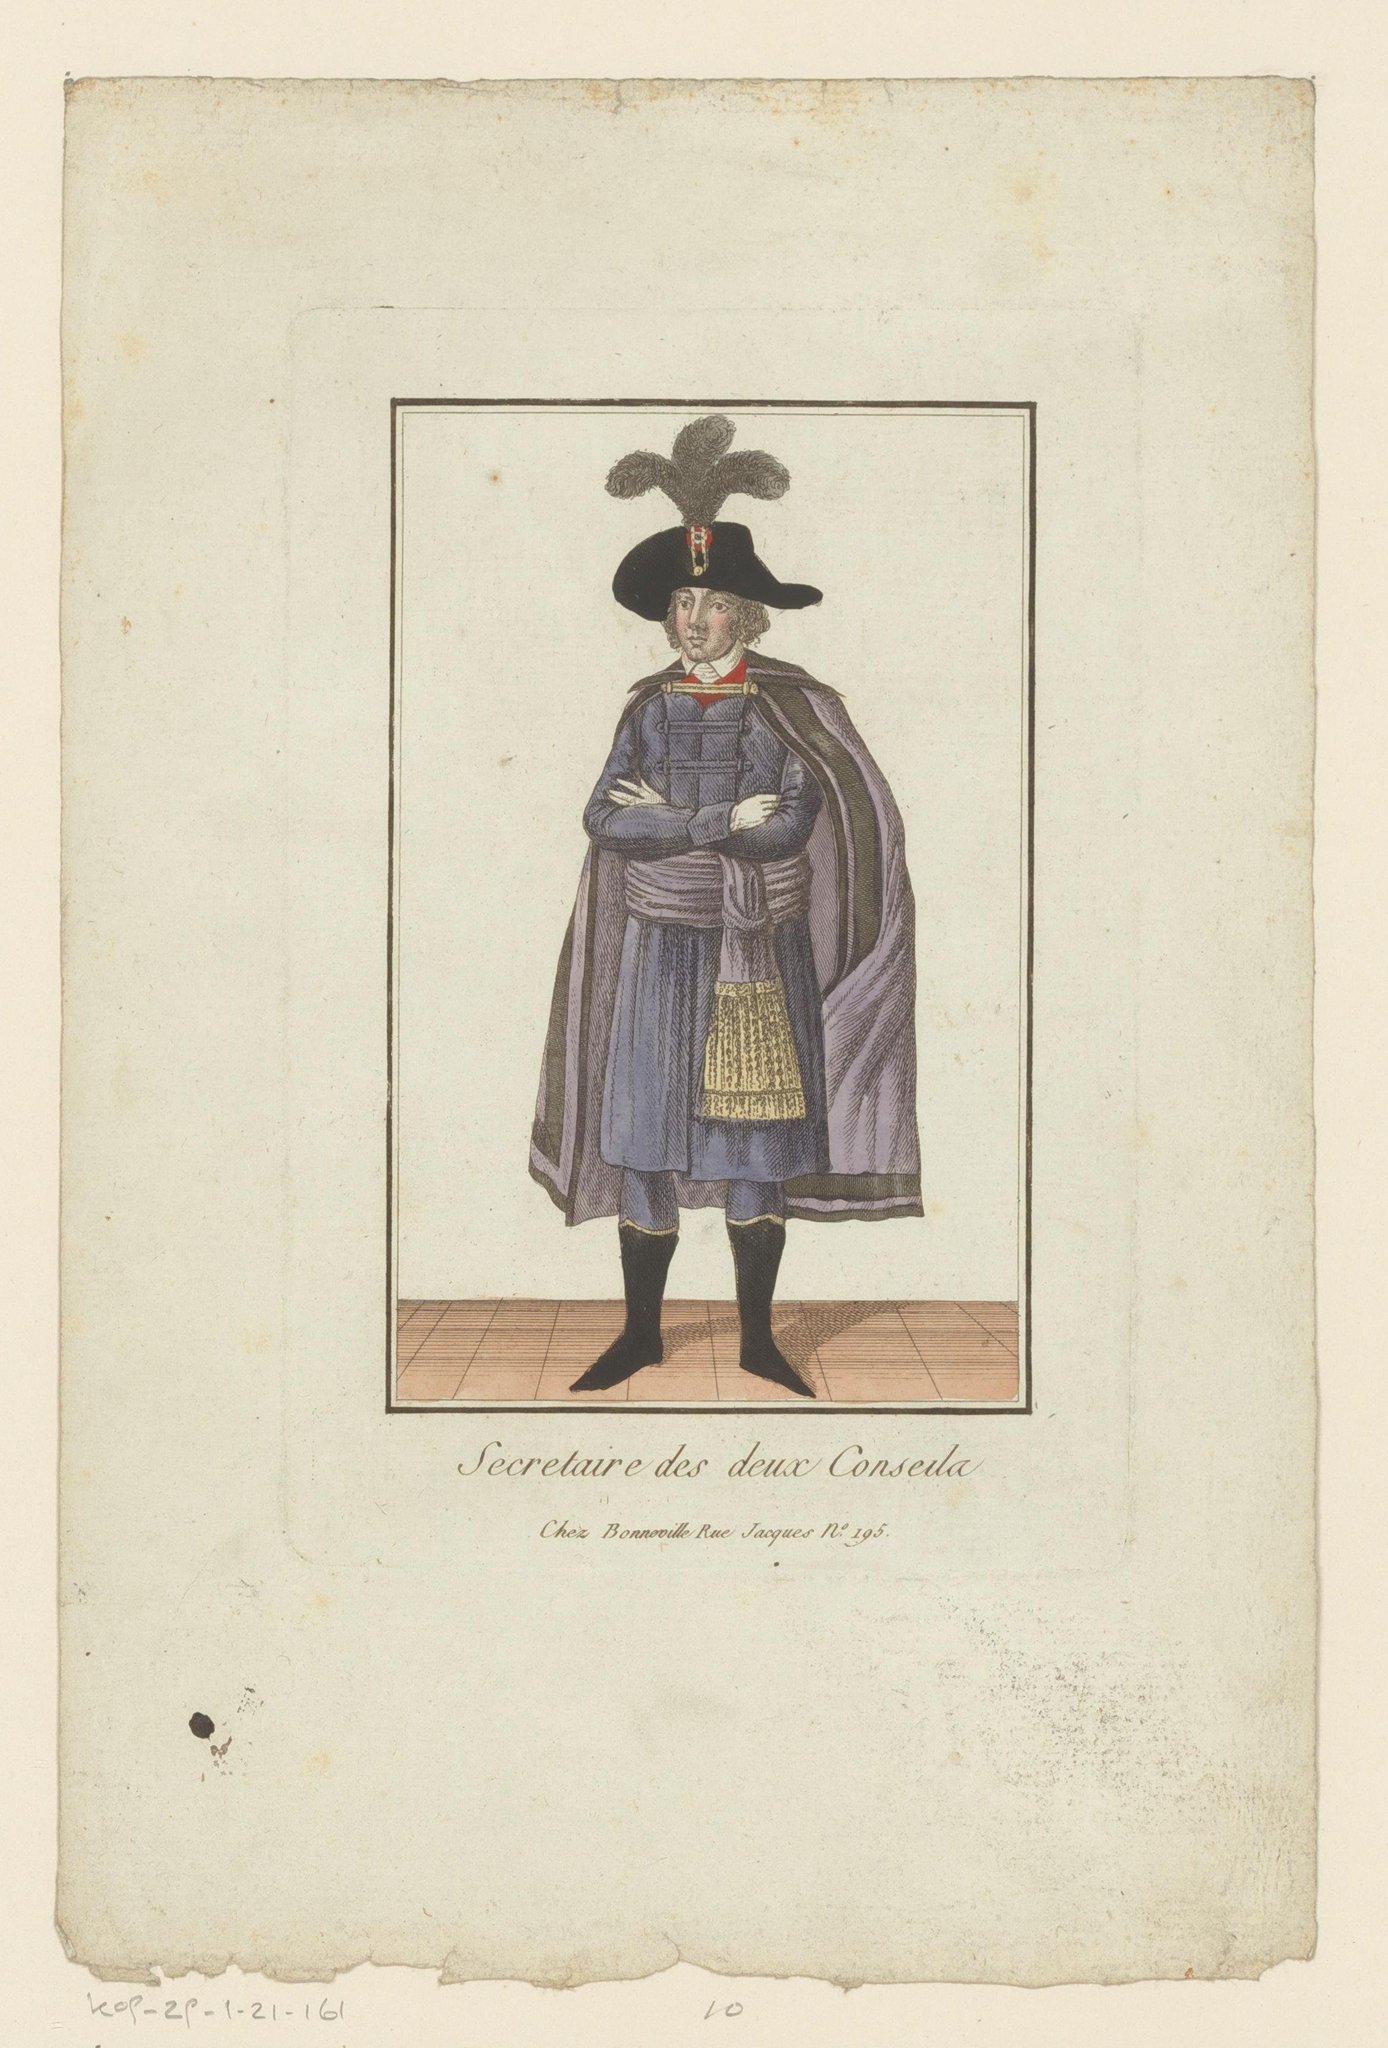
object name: print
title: Kostuums van de leden van twee raden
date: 1795-1799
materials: paper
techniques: etching, hand coloring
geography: paris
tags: standing figure, secretary of state, state secretary ~ government, national government, clothes, costume, head-gear: hat (+ feathers used for clothes)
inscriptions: stamp, collector's mark: Lugt 1641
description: Onderwerpsrubrieken binnen de Atlas Zeden en Gewoonten: Zeden en Gewoonten in Engeren Zin, De Kleeding, Kleederdrachten (tijdvakken), De Fransche Revolutie. (Het Directoire).